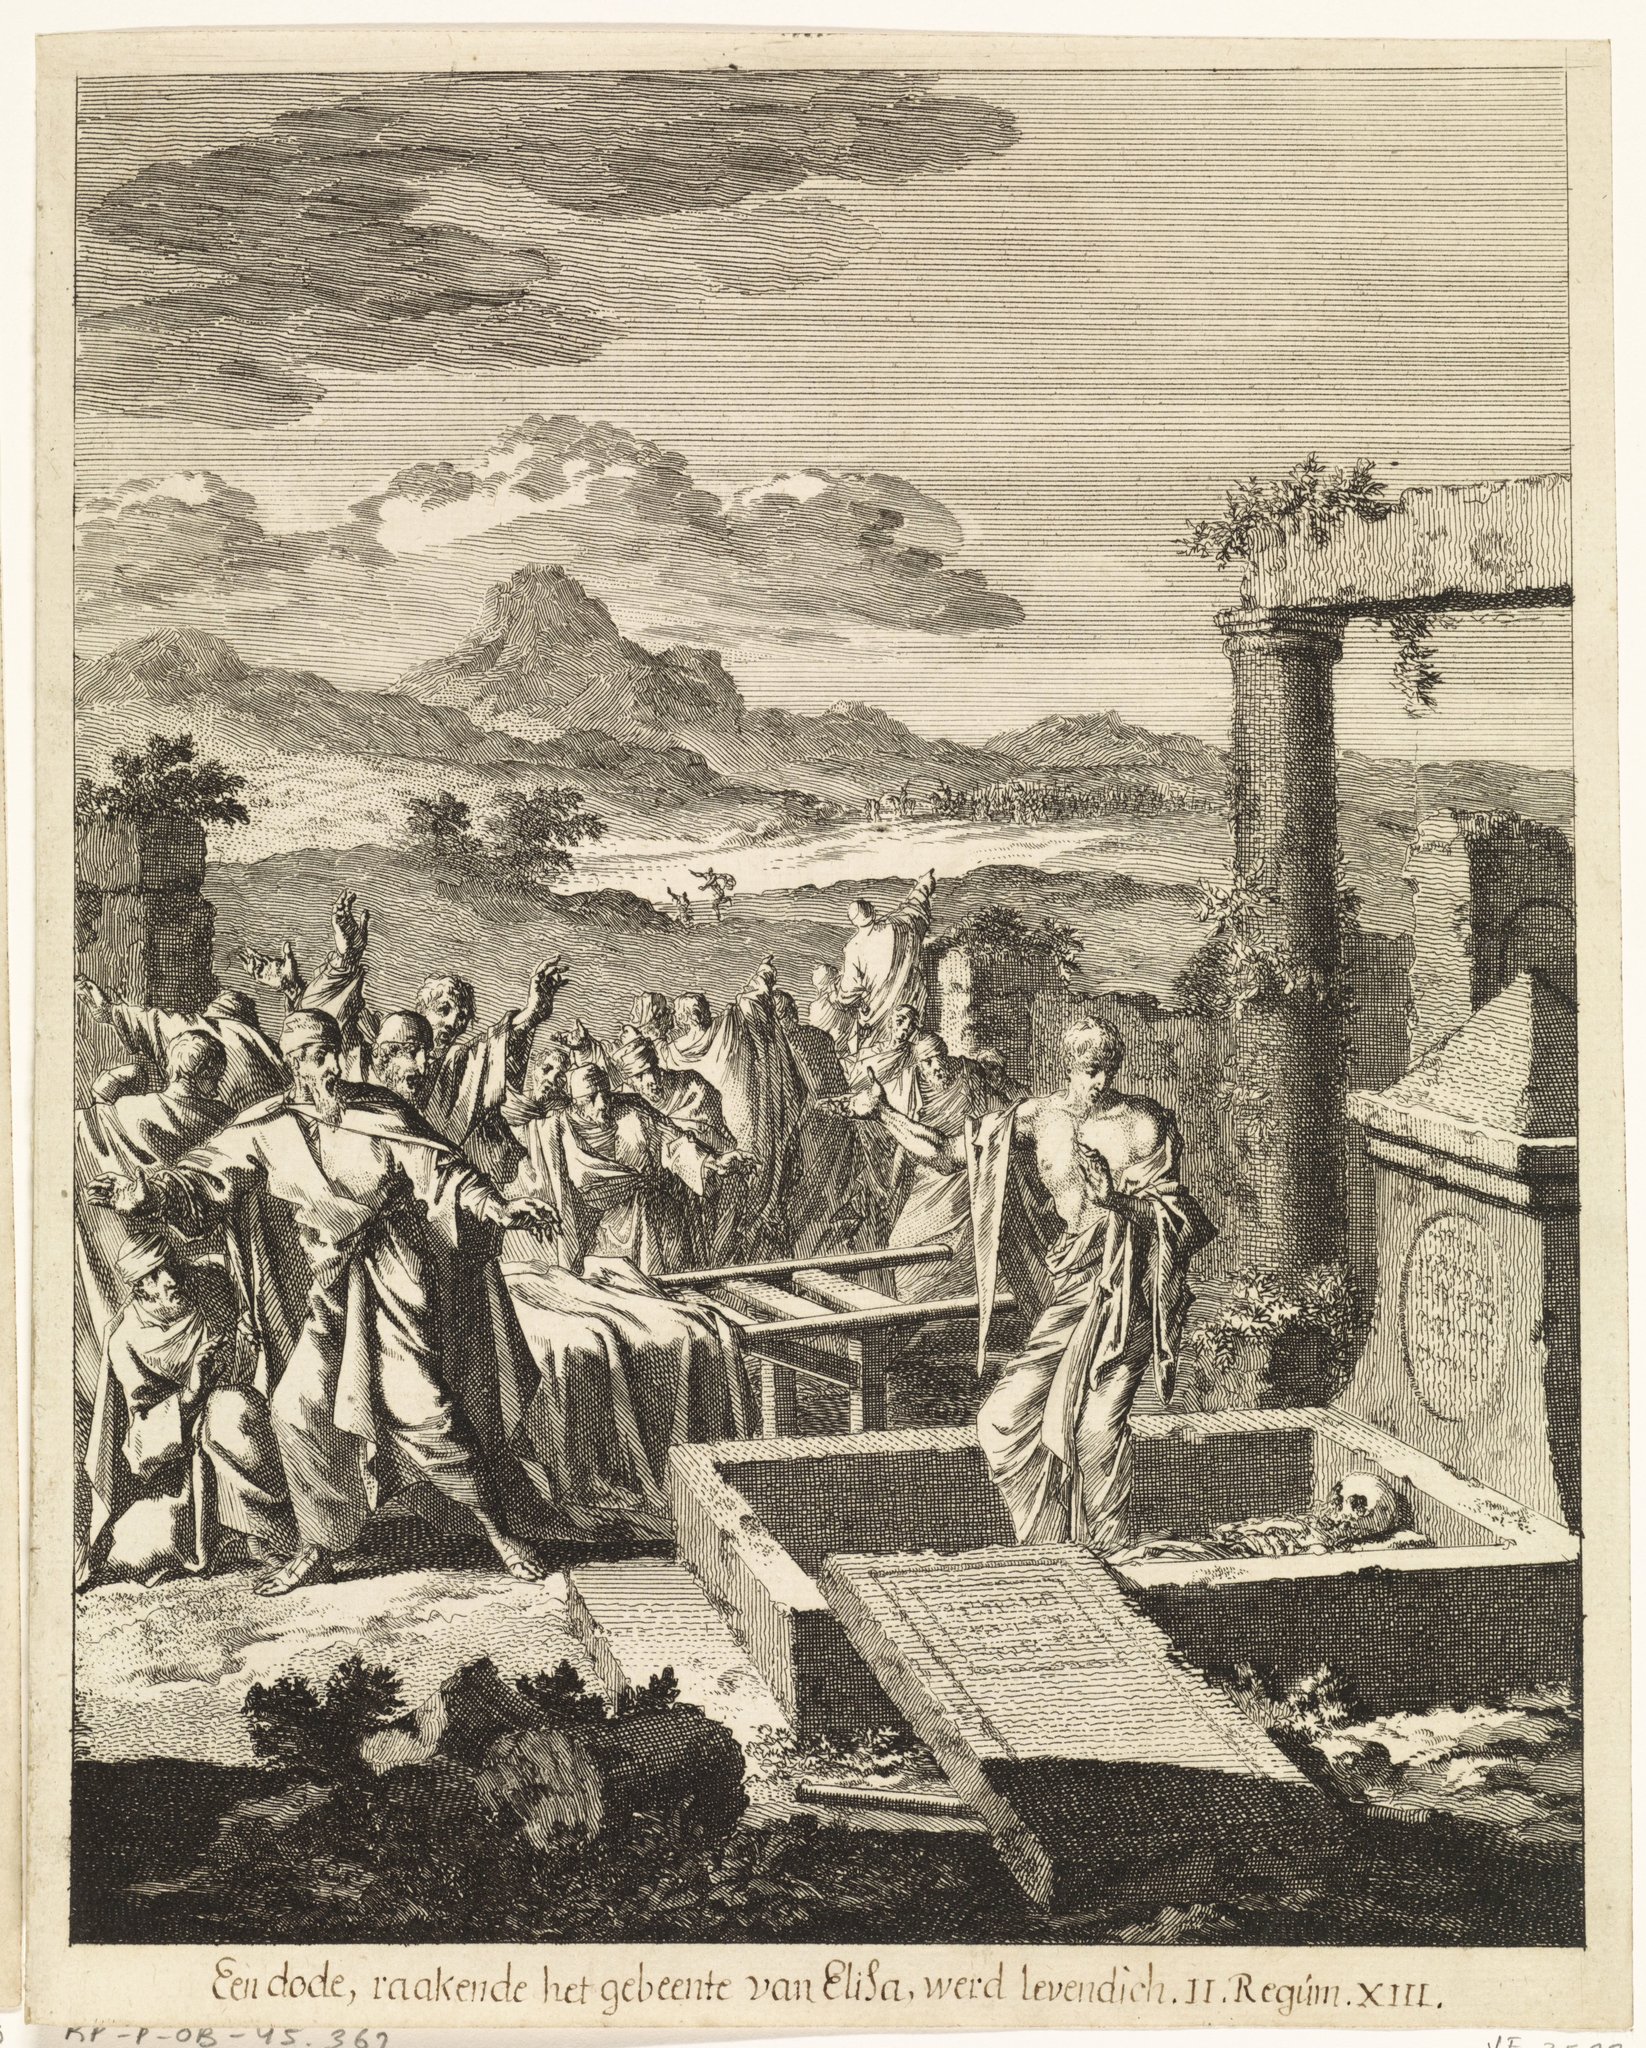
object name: print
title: Elisa's beenderen doen een overleden man tot leven komen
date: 1708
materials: paper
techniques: etching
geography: amsterdam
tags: during a funeral a band of ransacking moabites is seen approaching and the corpse is thrown hastily into elisha's tomb; when it touches elisha's bones the man comes back to life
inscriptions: collector's mark: Lugt 2228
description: Proefdruk van een prent welke is opgenomen als illustratie in: Historiae Celebriores Veteris Testamenti. Christoph Weigel, 1708.